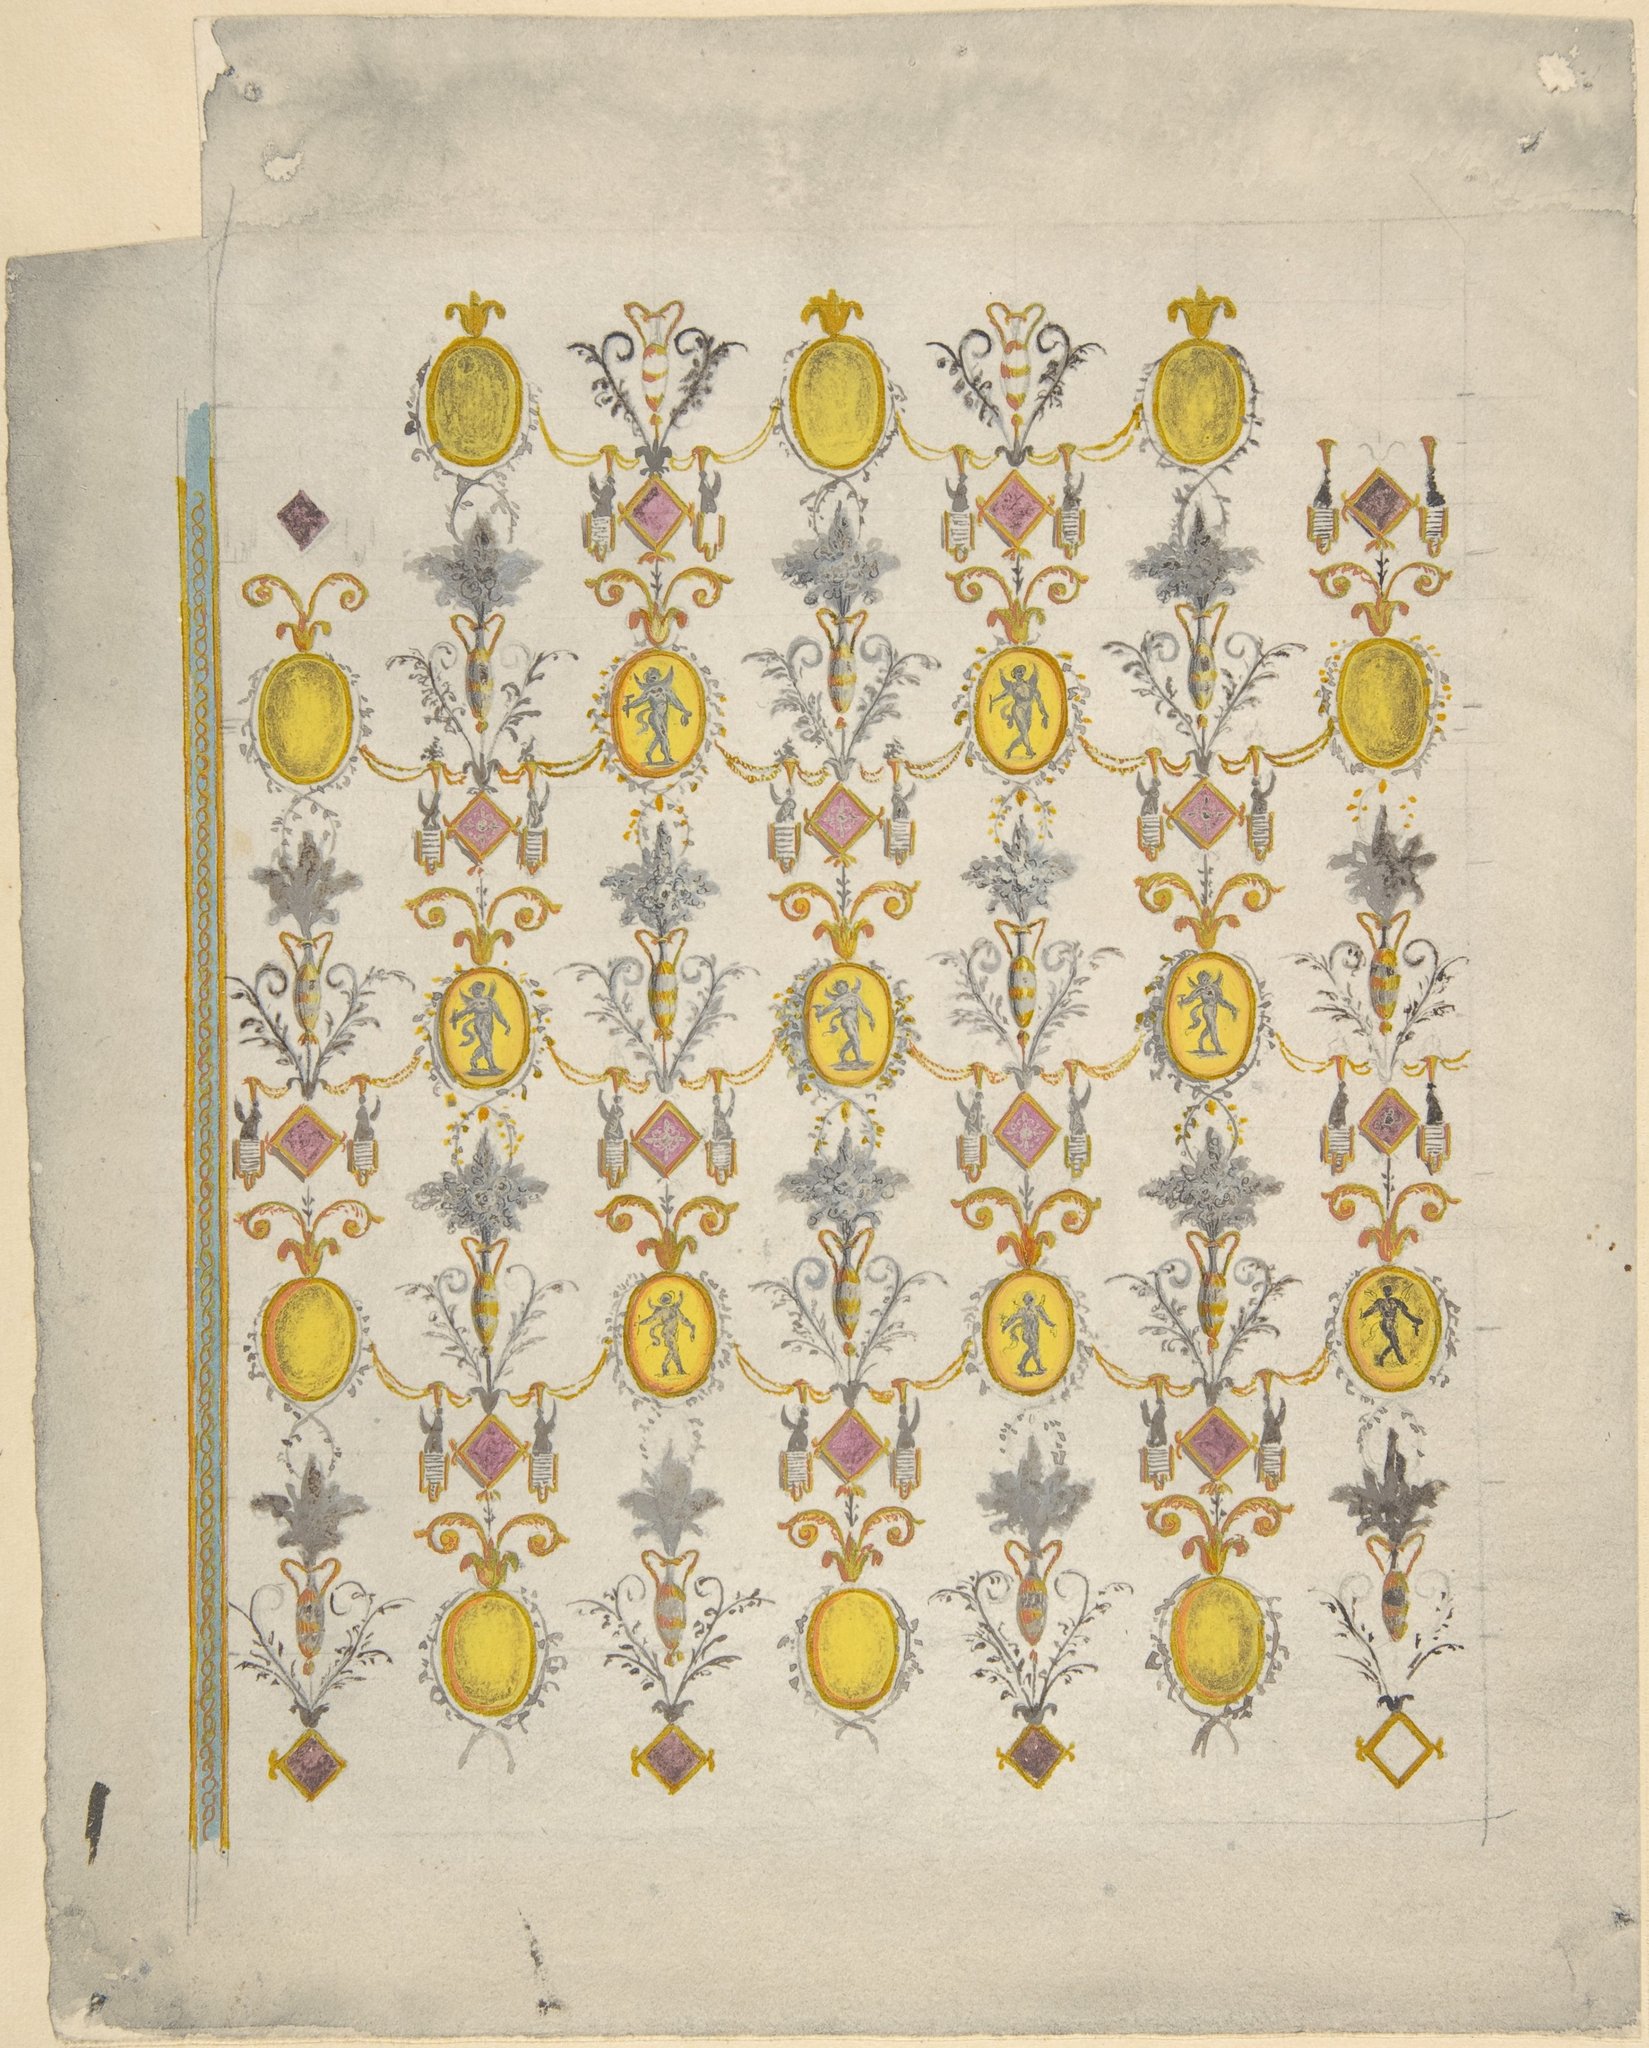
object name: drawing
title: Design for ceiling decoration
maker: joseph bonomi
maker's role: artist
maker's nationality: italian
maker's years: 1739-1808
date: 1734-1833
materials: graphite, watercolor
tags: ceilings